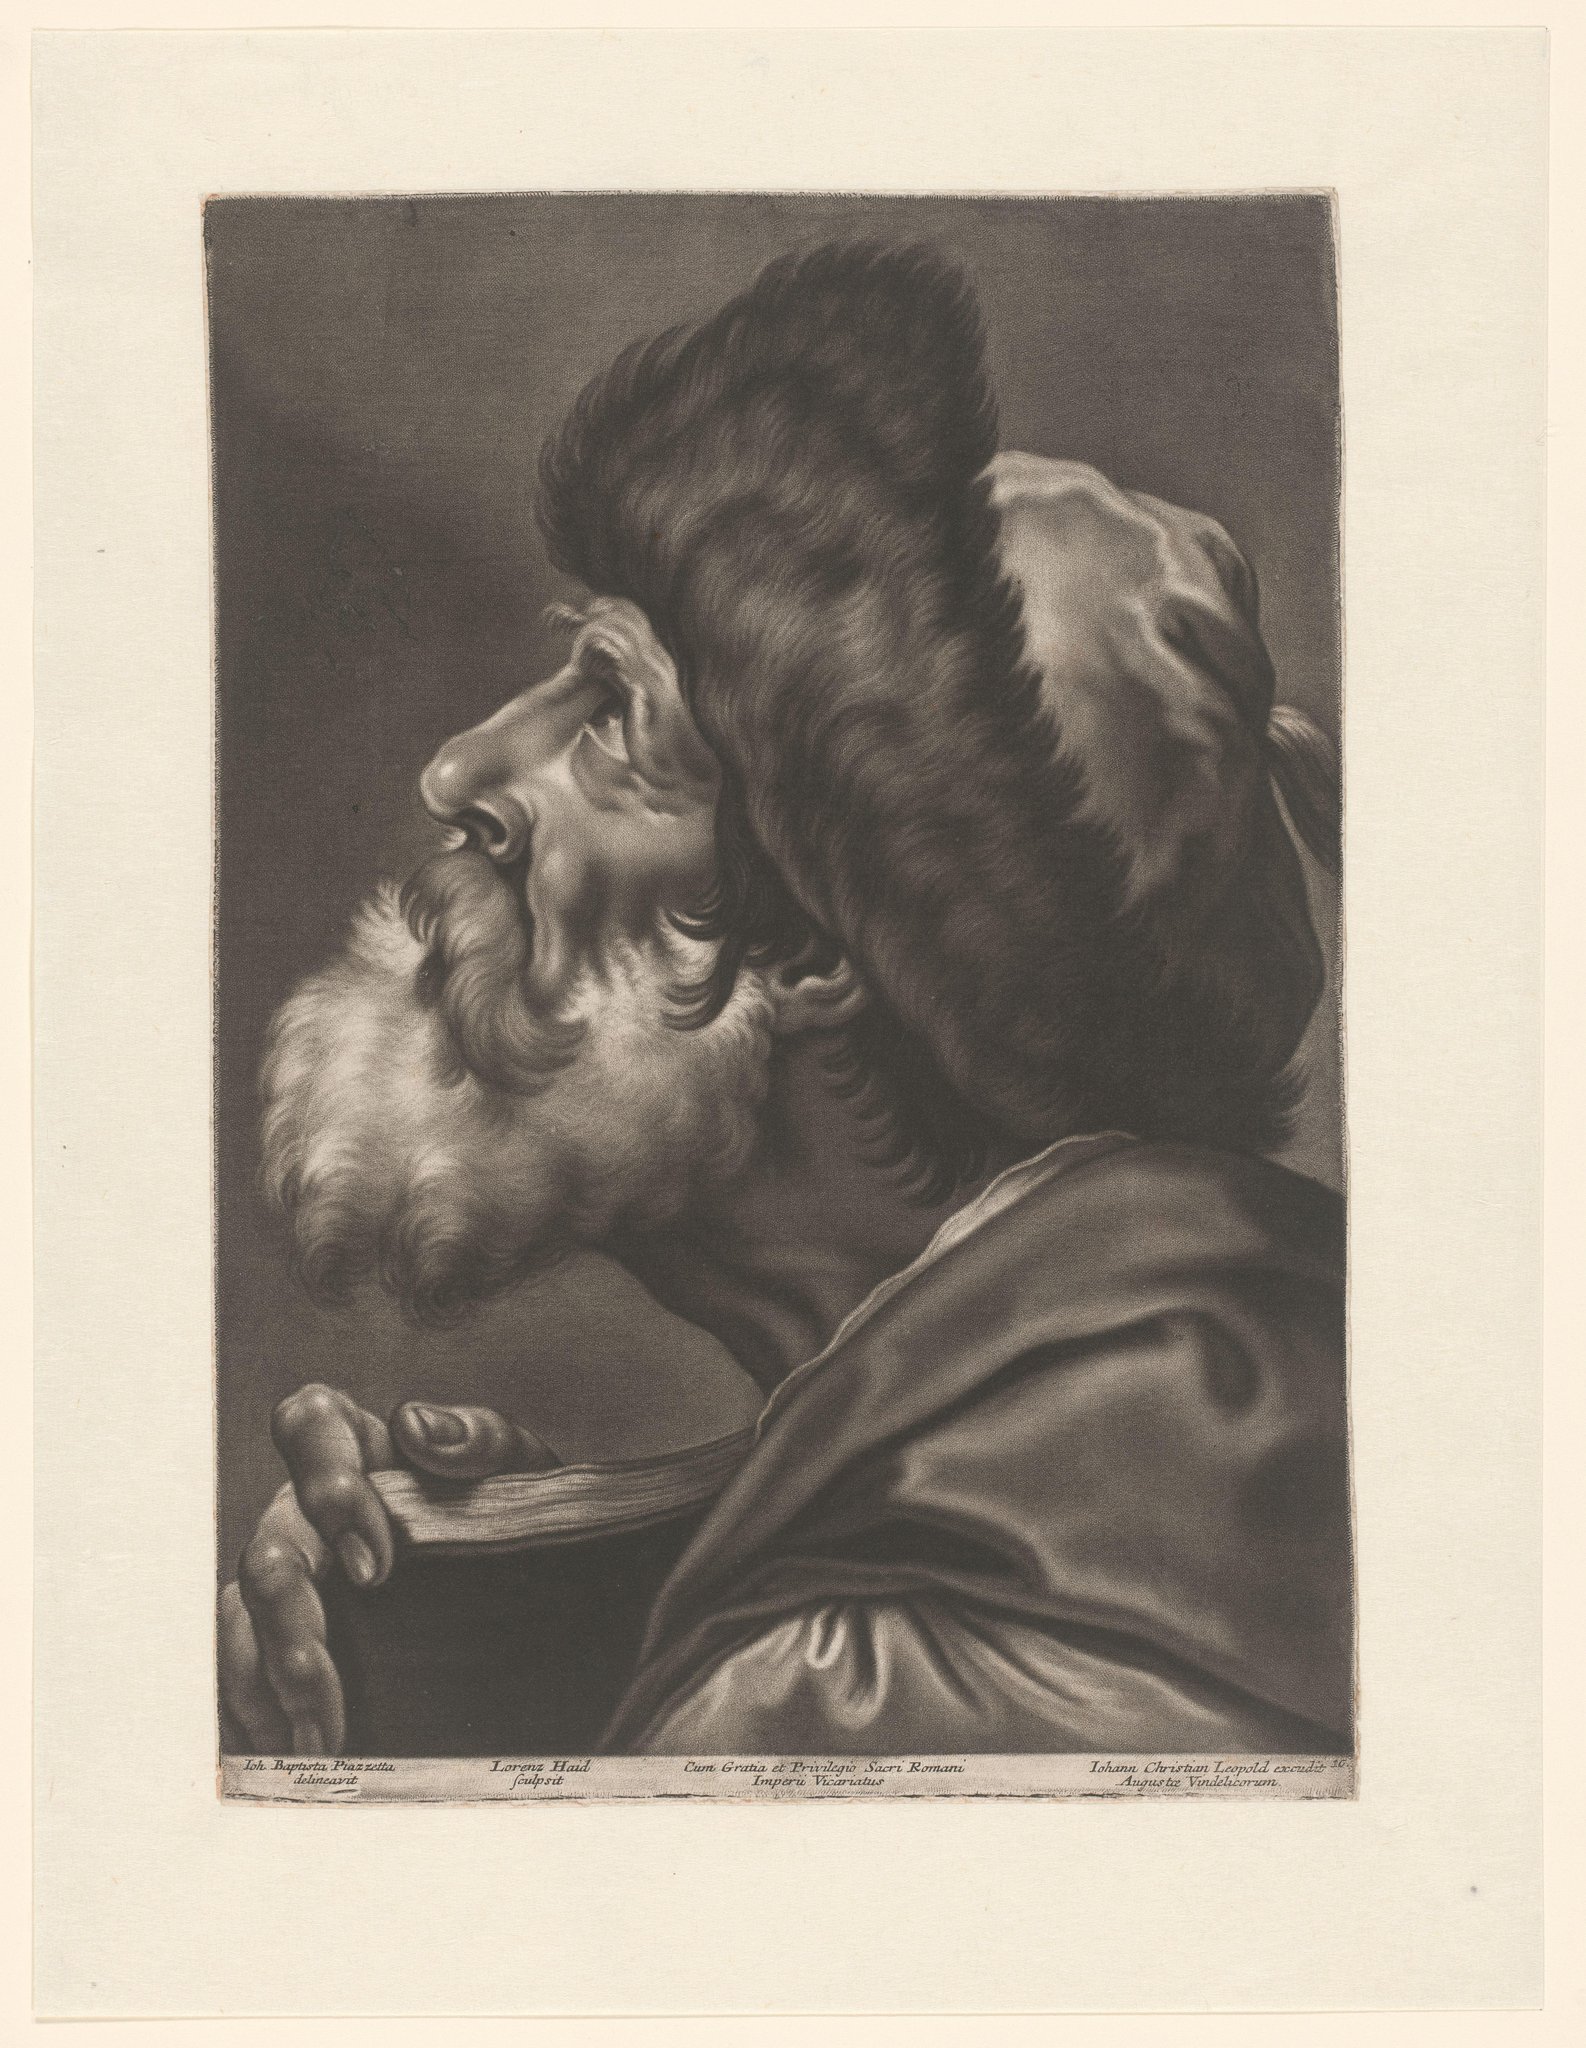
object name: print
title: Omhoogkijkende man met bontmuts en boek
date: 1712-1750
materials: paper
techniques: mezzotint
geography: germany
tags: head-gear (with name), old man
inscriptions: collector's mark: Lugt 2228, collector's mark: Lugt 240